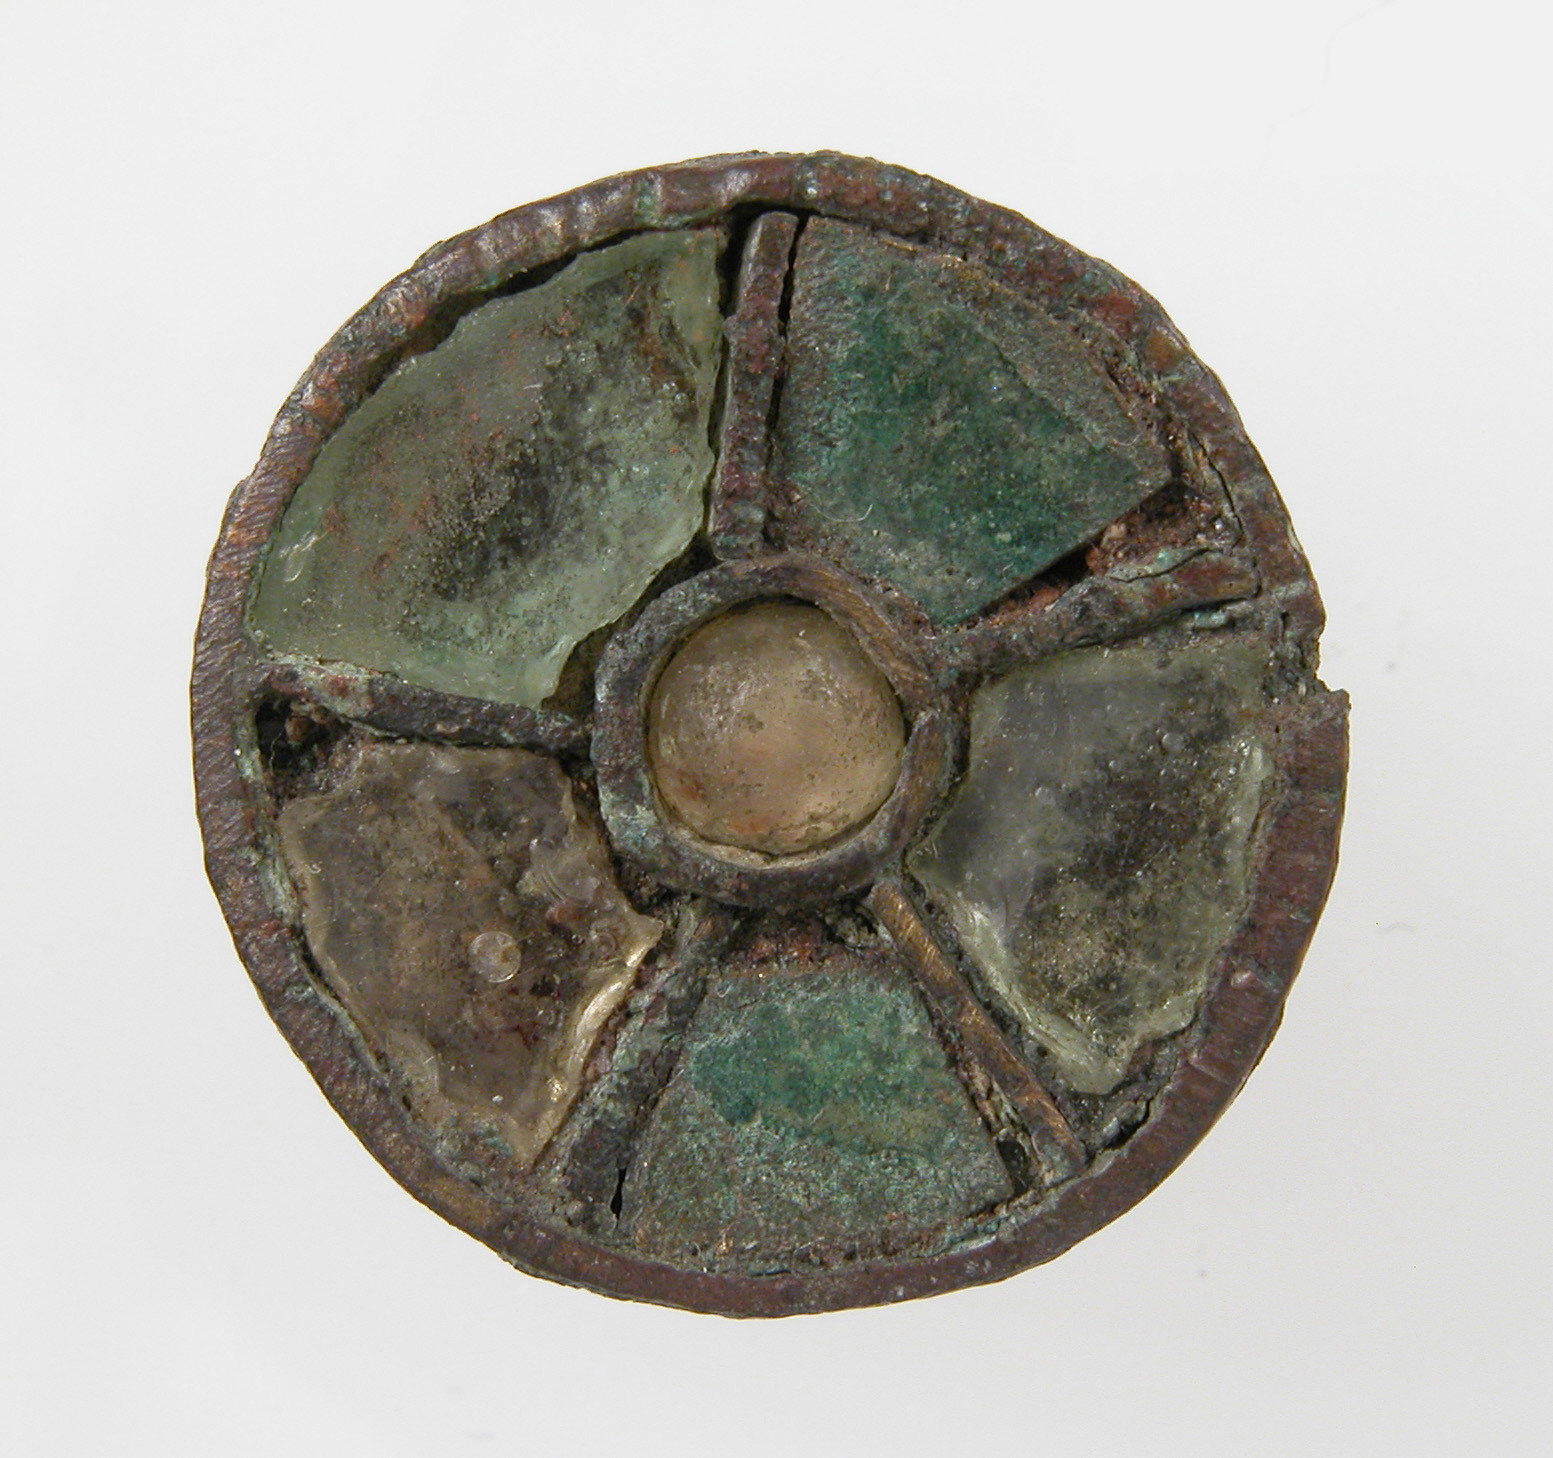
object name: brooch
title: Disk Brooch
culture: frankish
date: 501-600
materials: copper alloy, glass, paste